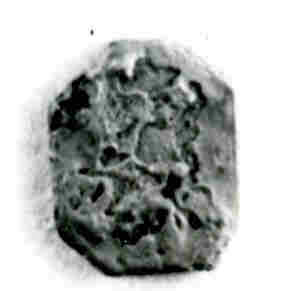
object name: coin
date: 701-900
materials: copper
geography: iran